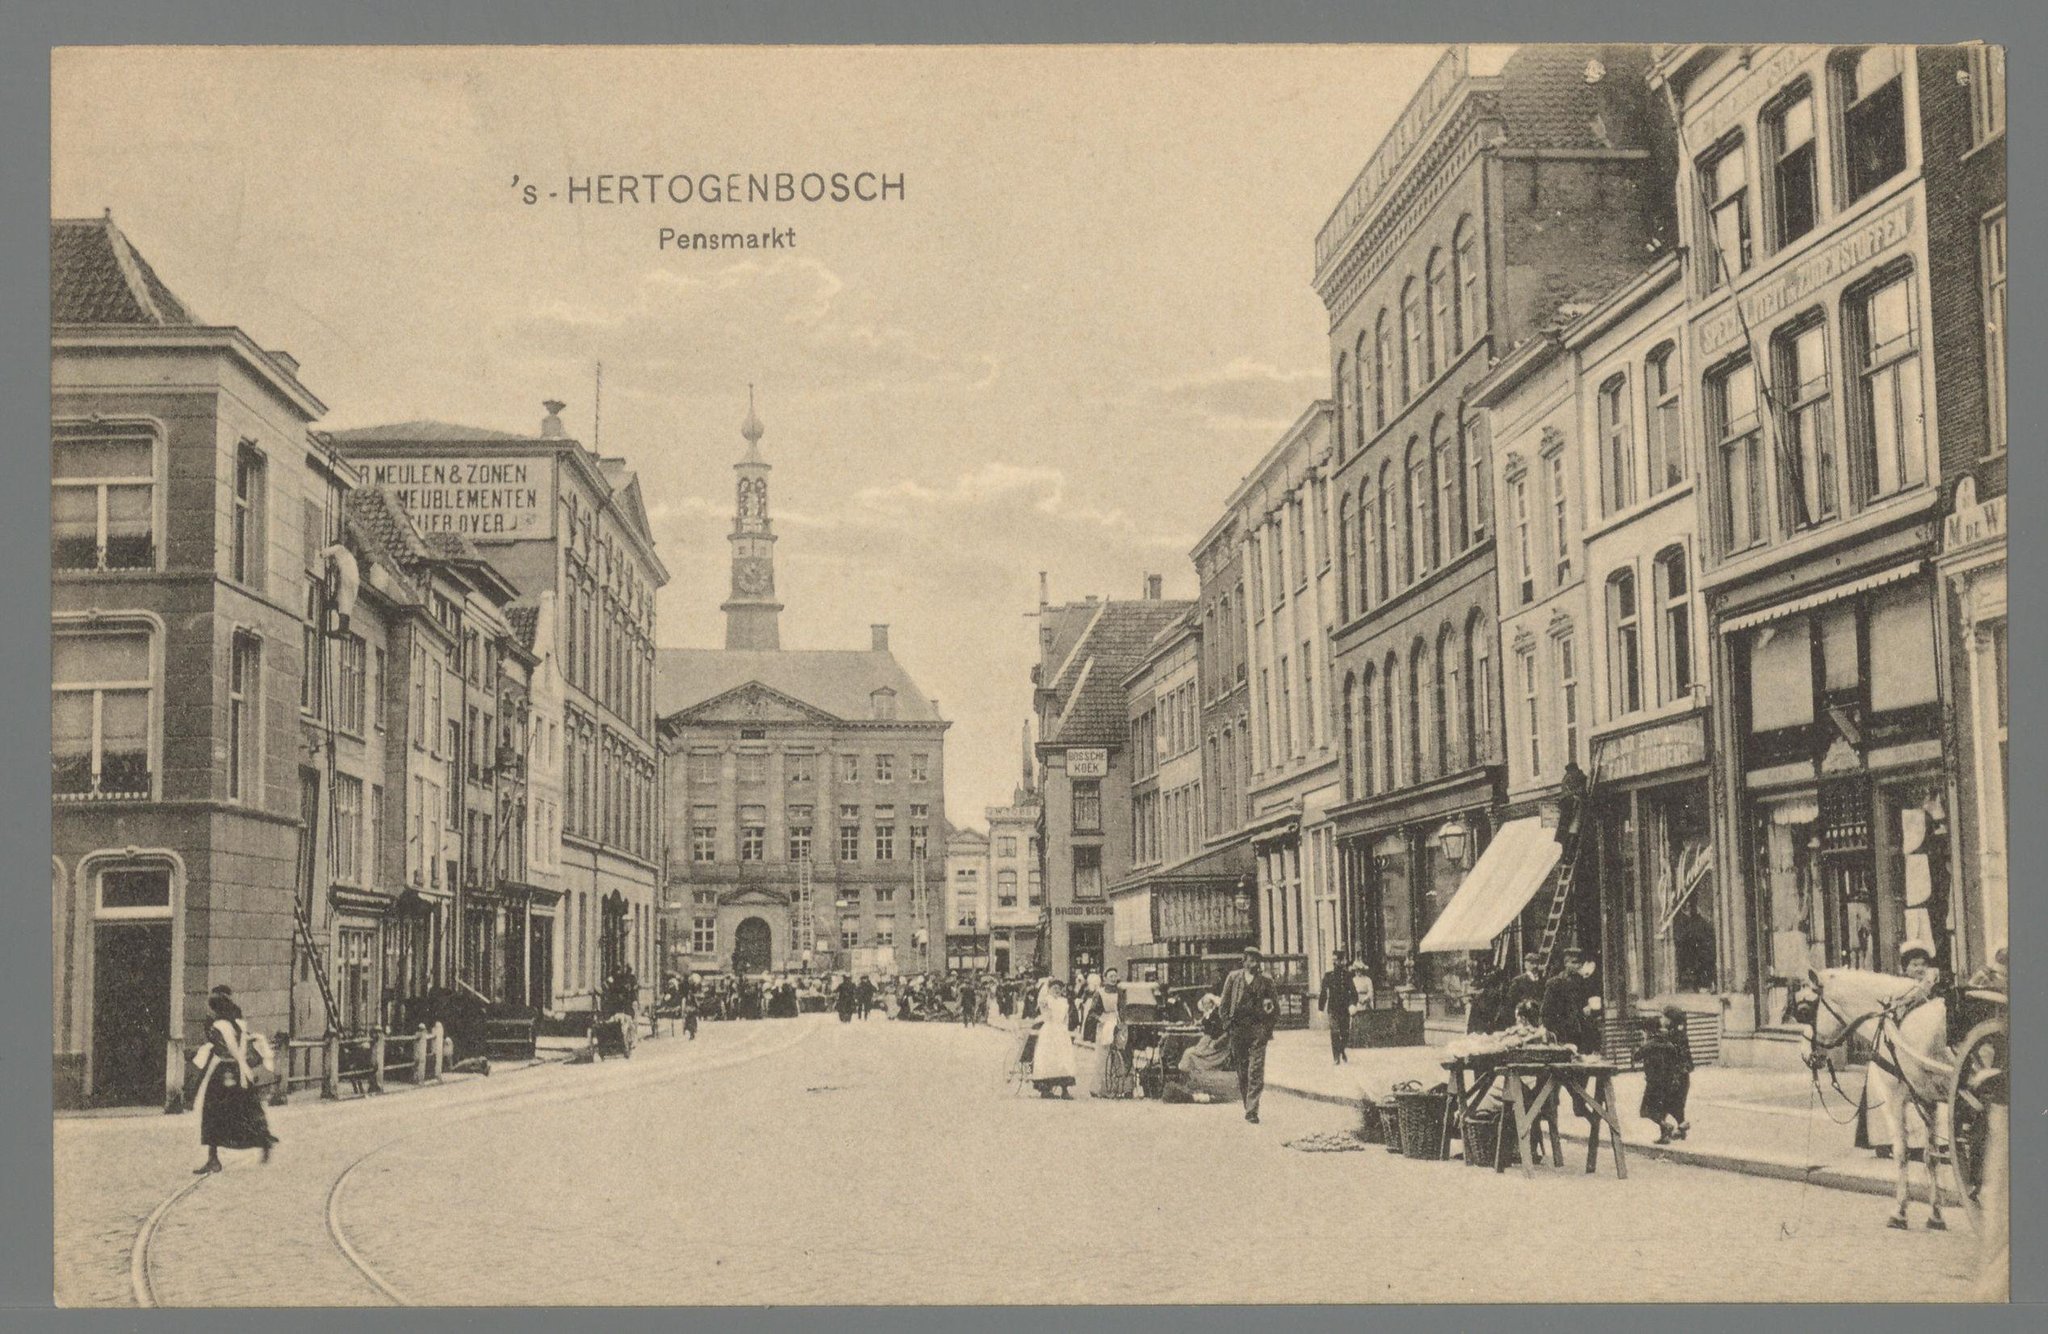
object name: ansichtkaart, prentbriefkaart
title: 's-Hertogenbosch. Pensmarkt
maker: Anonymous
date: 1907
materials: cardboard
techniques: photograph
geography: den bosch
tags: townhall, street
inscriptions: date